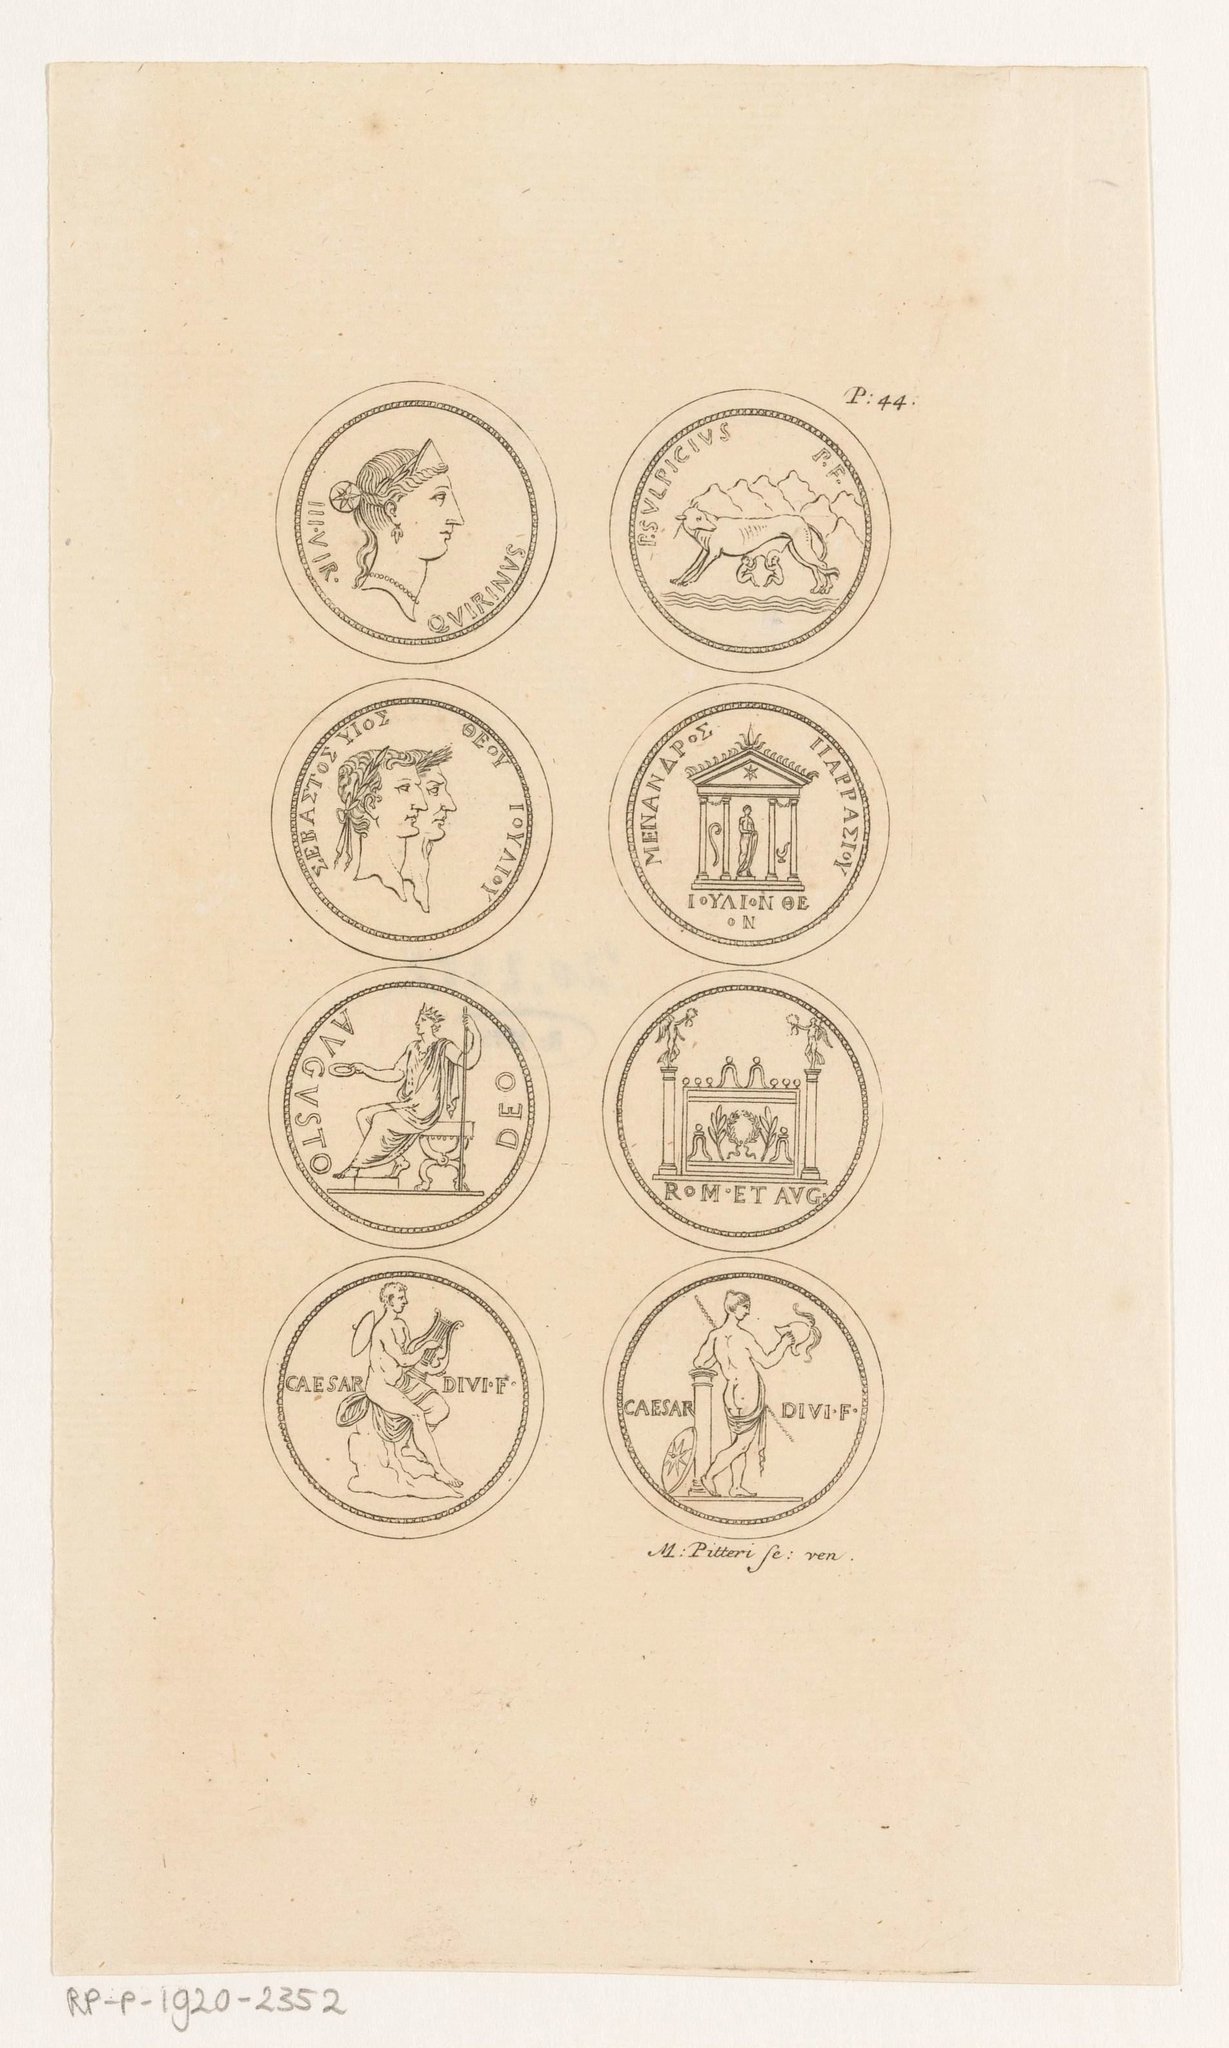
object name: print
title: Acht ontwerpen voor penningen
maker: giovanni marco pitteri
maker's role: print maker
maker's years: 1702-1786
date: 1712-1786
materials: paper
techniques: engraving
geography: venice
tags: medal (considered as a piece of sculpture, regardless of its specific function)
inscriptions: collector's mark: Lugt 2228